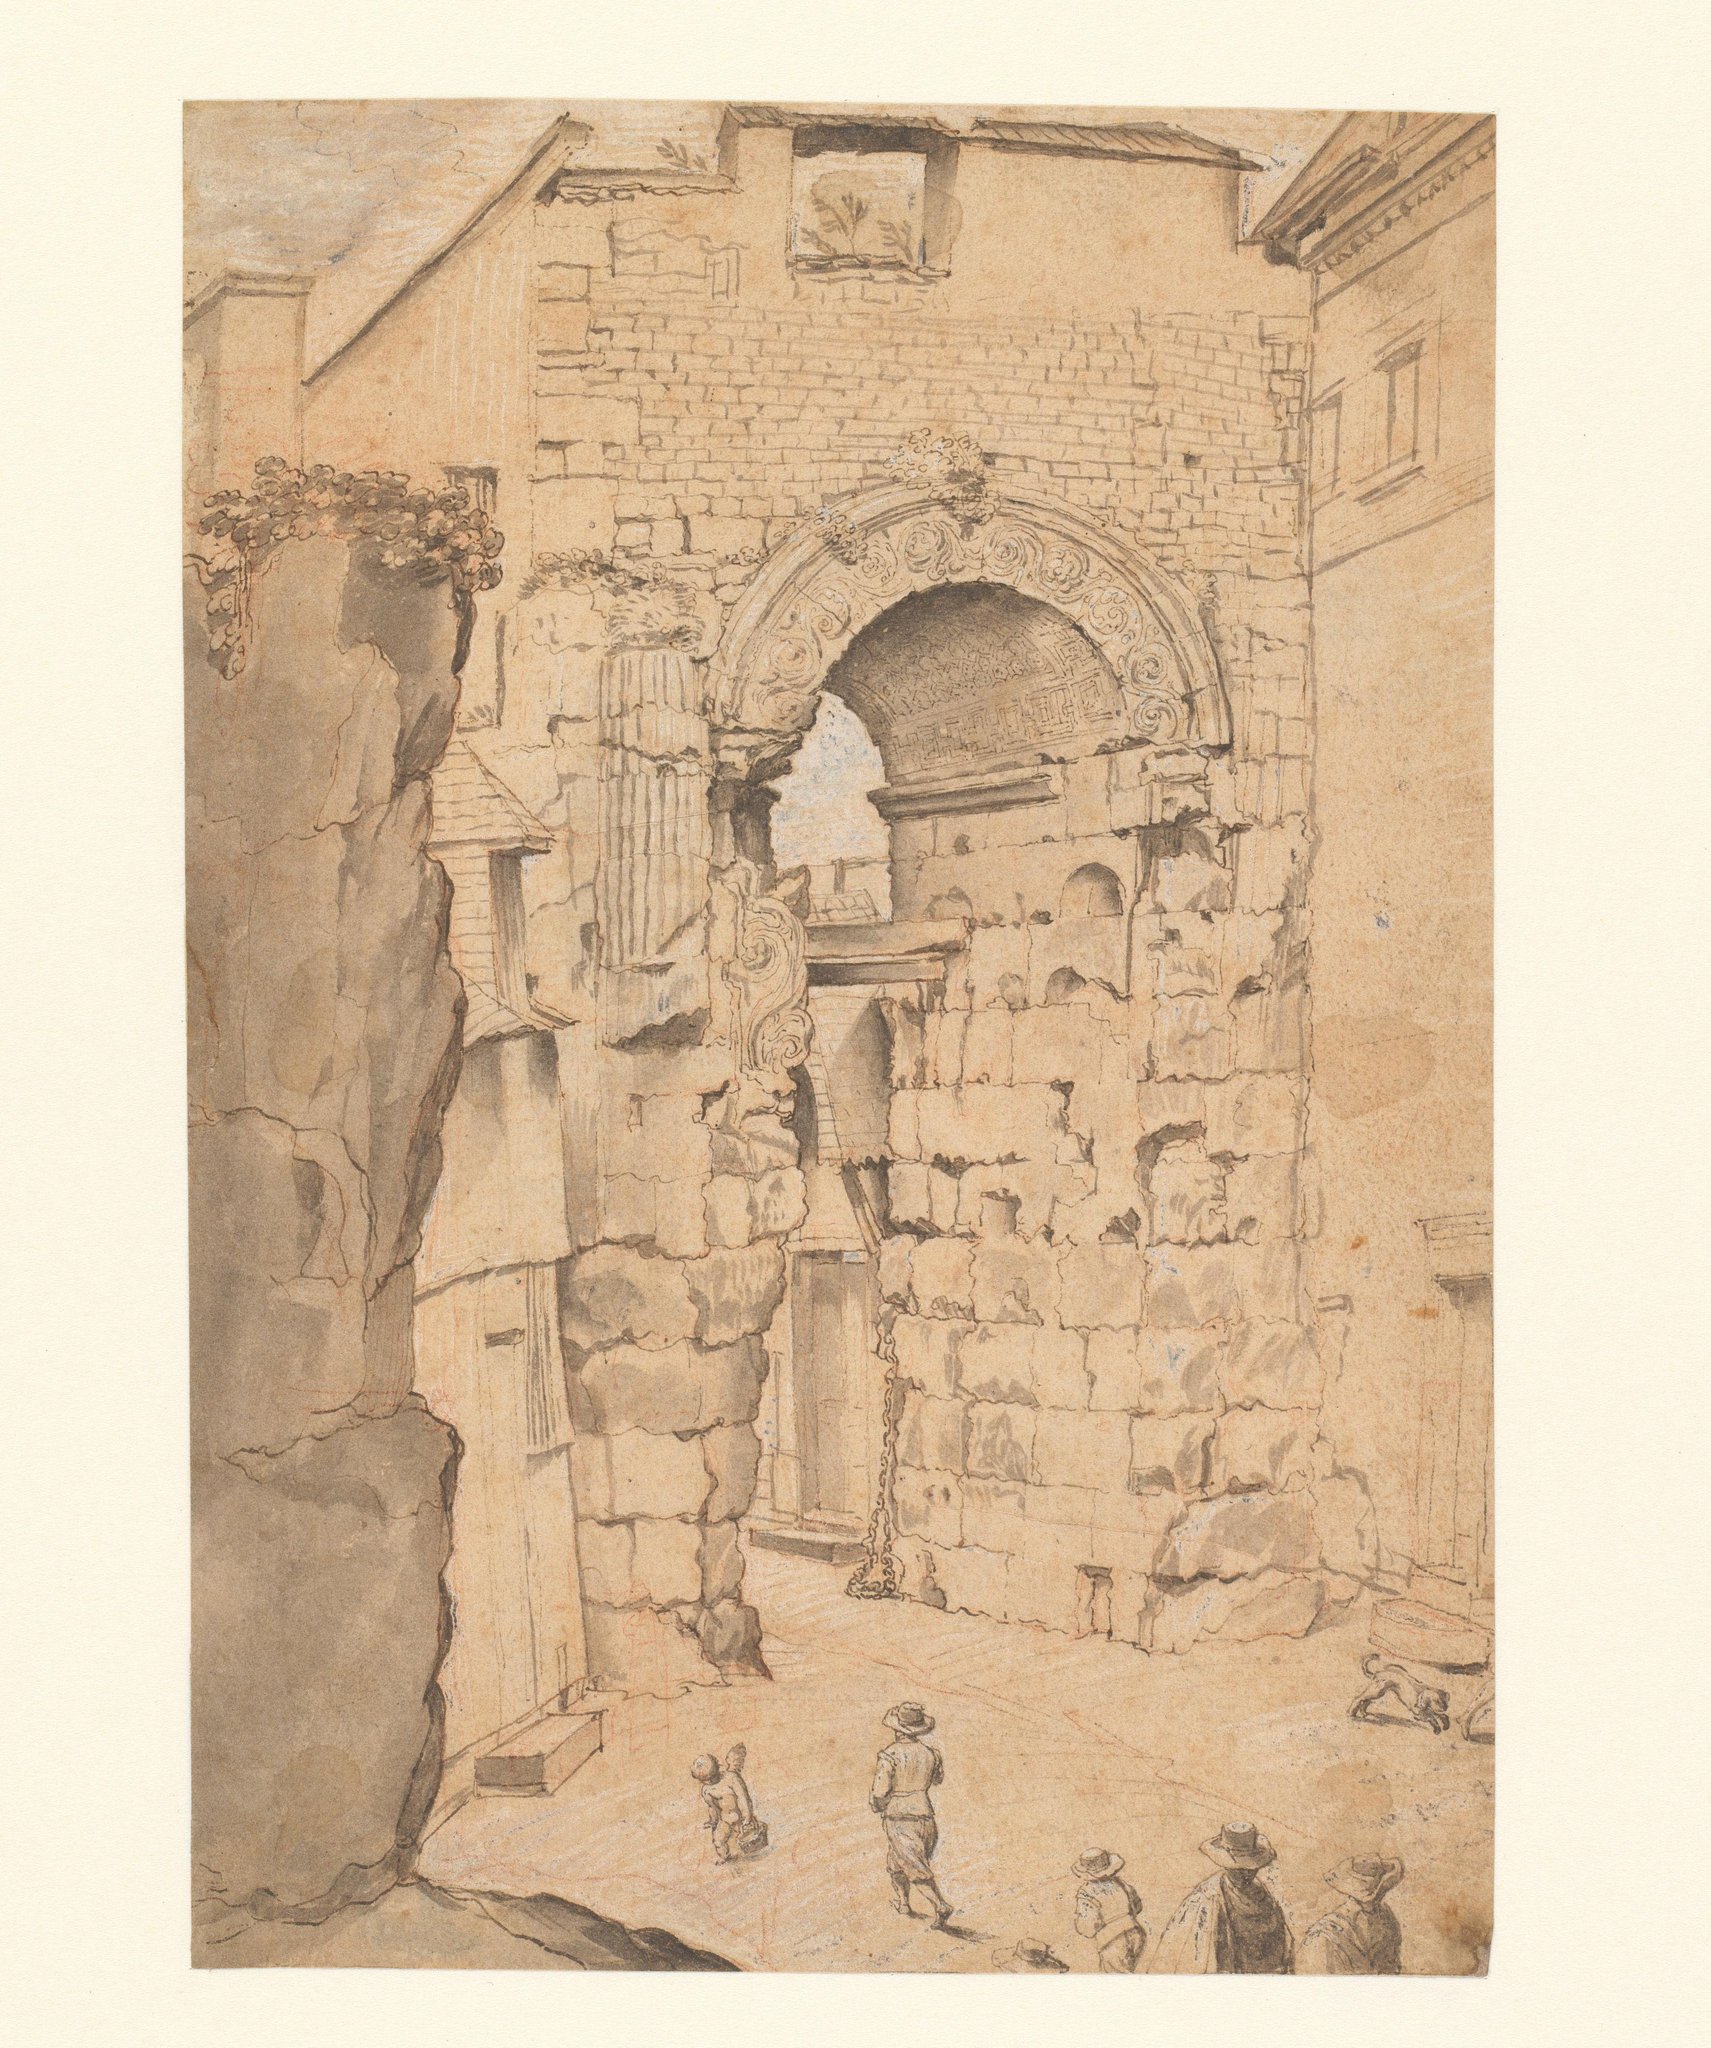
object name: drawing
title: Wandelaars bij een antieke stadspoort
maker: Anonymous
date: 1575-1625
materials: chalk, paint, ink, paper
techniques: brush, pen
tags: city-gate